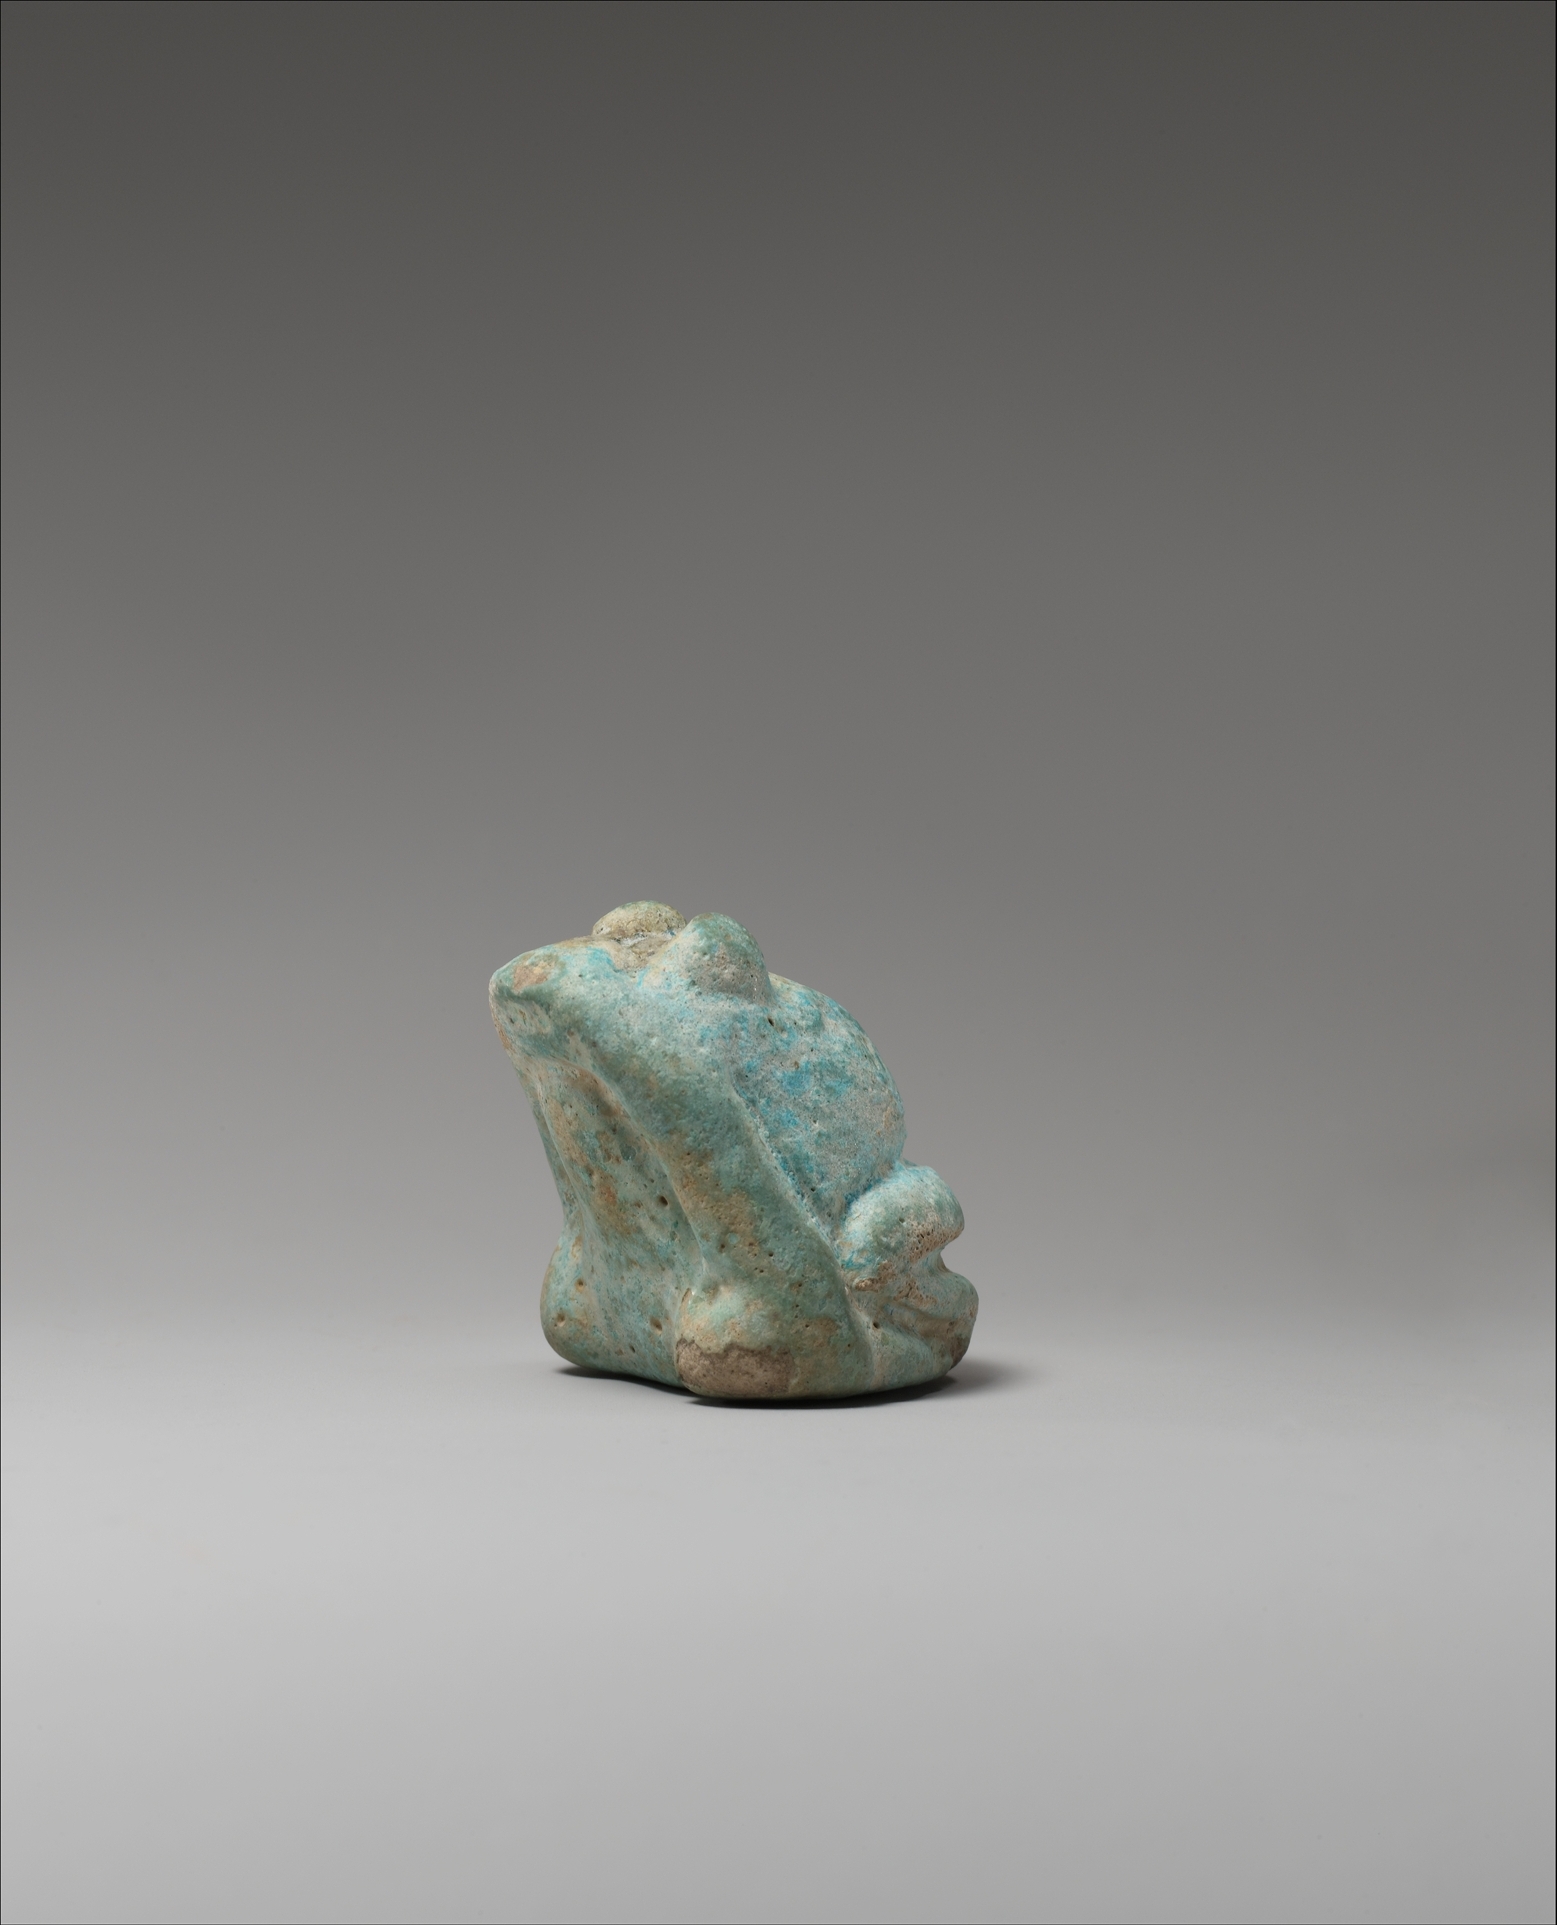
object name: amulet, frog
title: Frog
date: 3100-2650 BCE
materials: faience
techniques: glazing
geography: egypt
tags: frogs